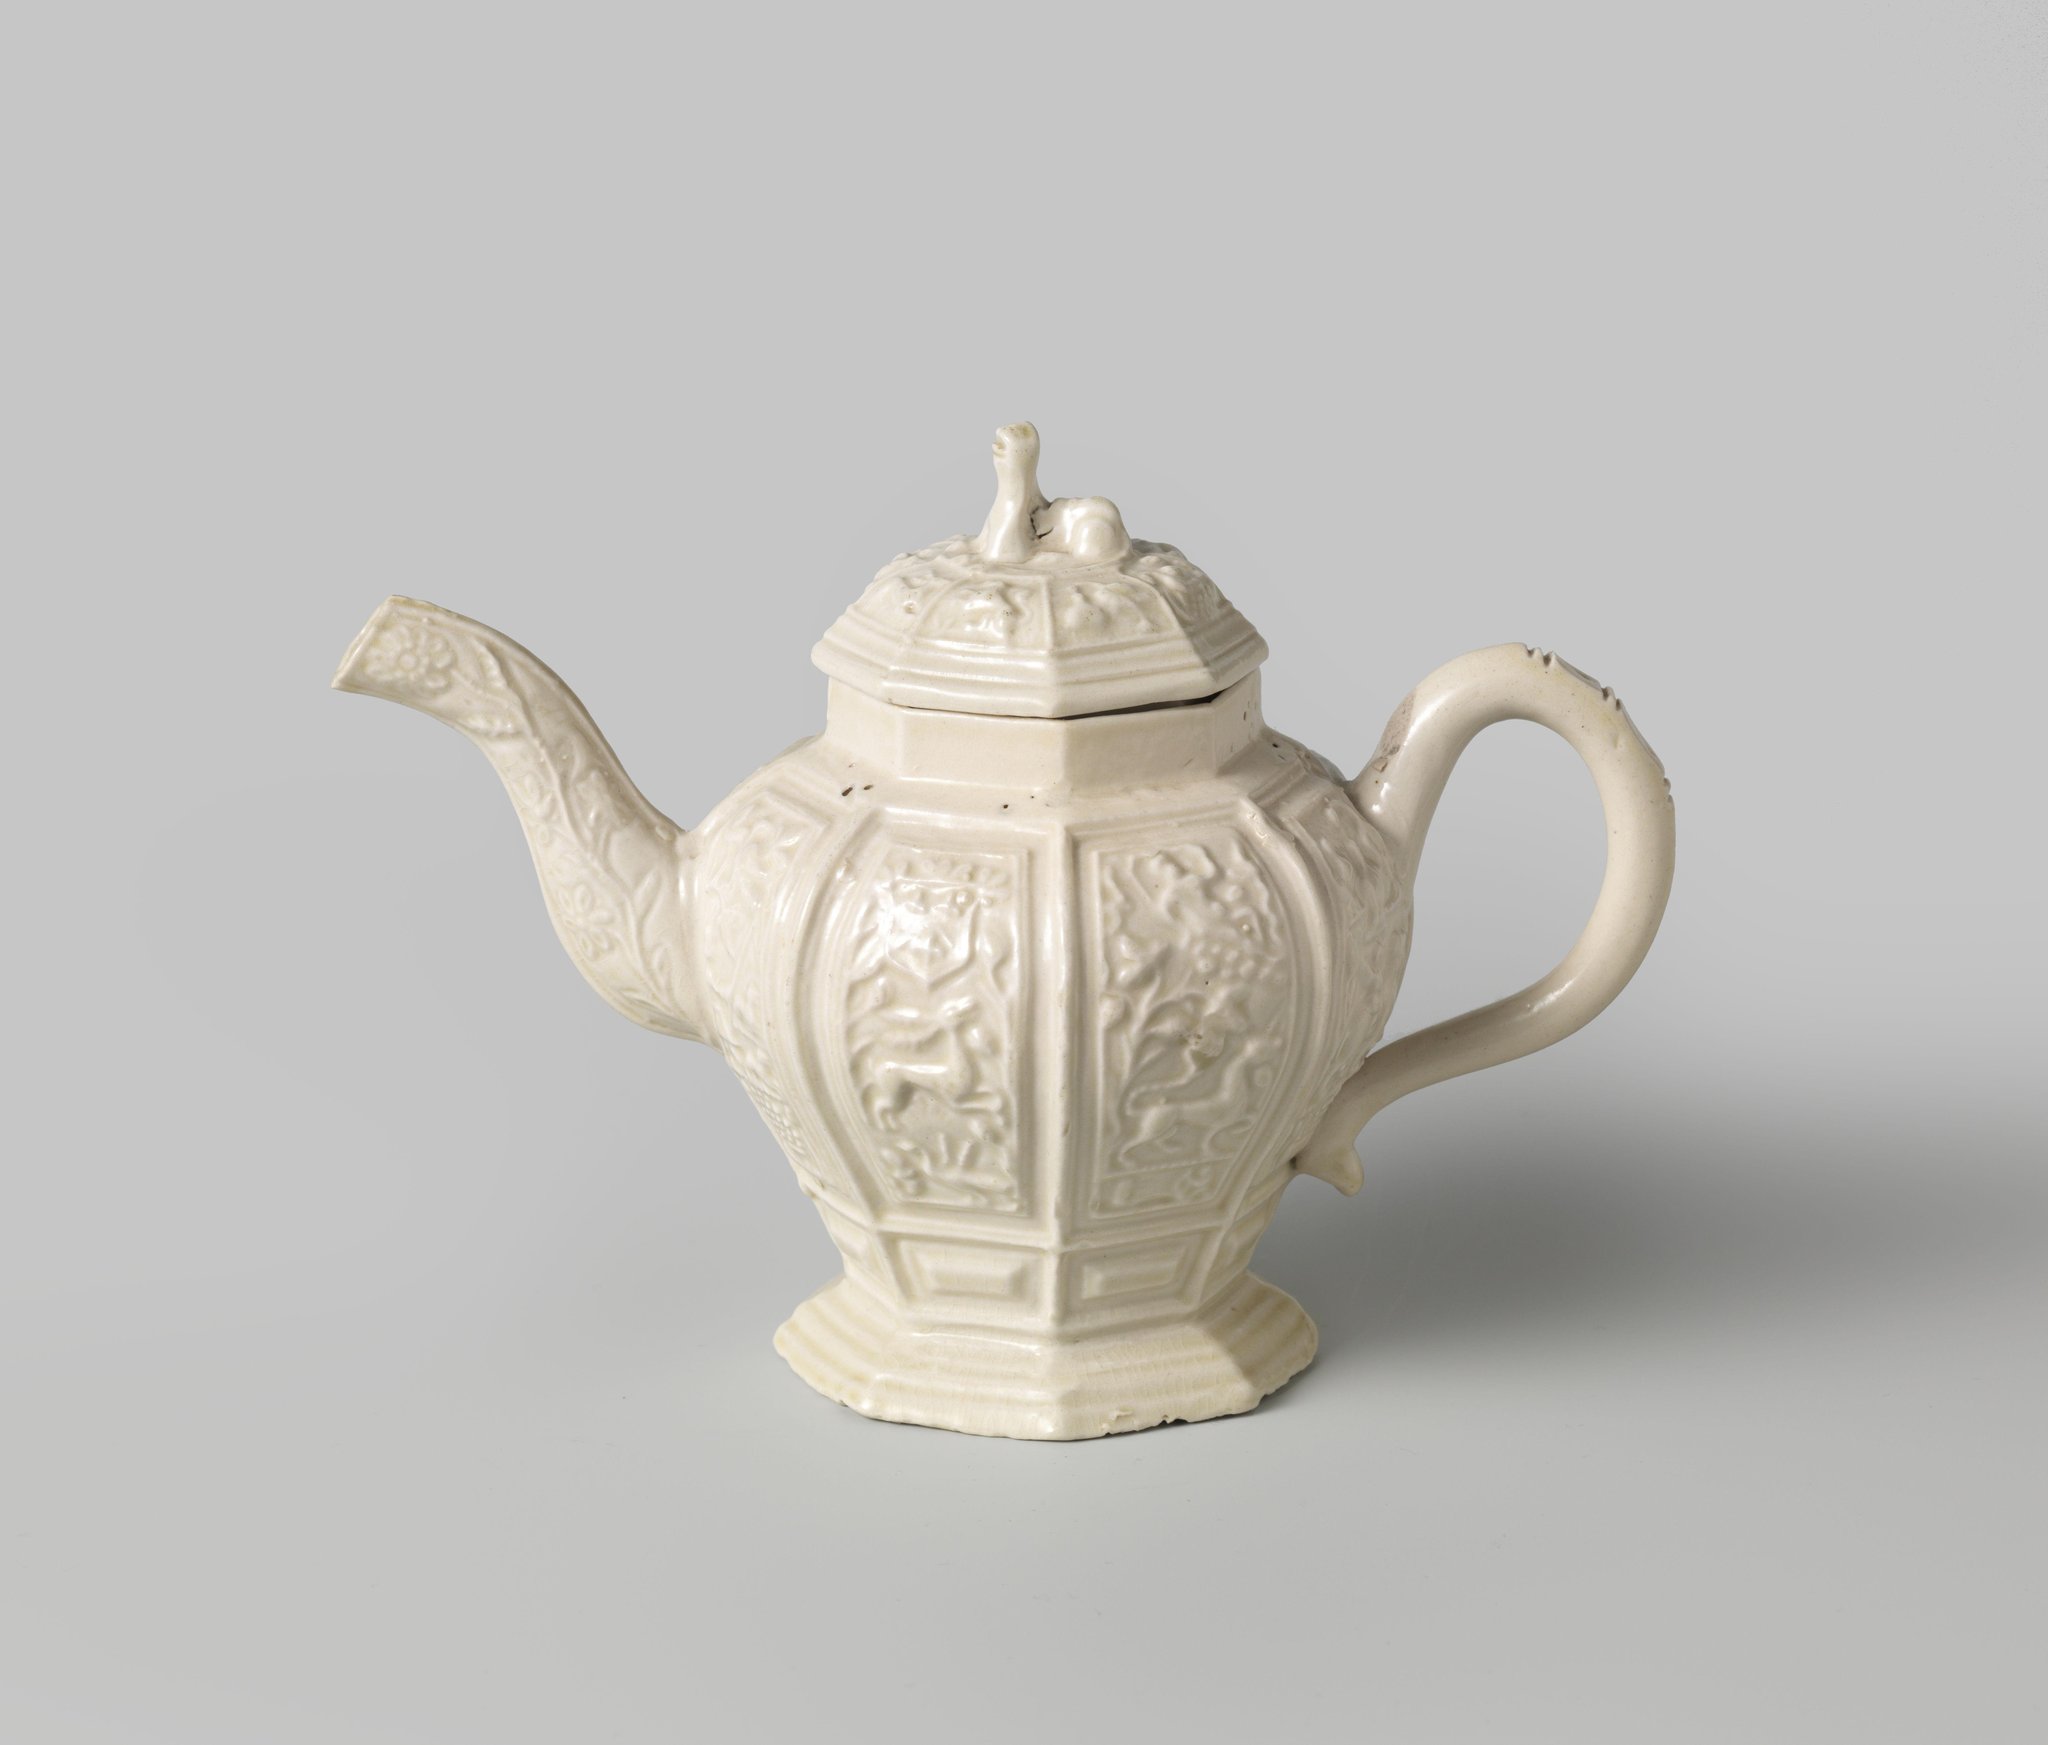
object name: lid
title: Deksel van van steengoed met zoutglazuur; Staffordshire.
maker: Anonymous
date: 1740-1760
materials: stoneware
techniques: salt glaze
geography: england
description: Het deksel heeft een leeuw of hond als knop.